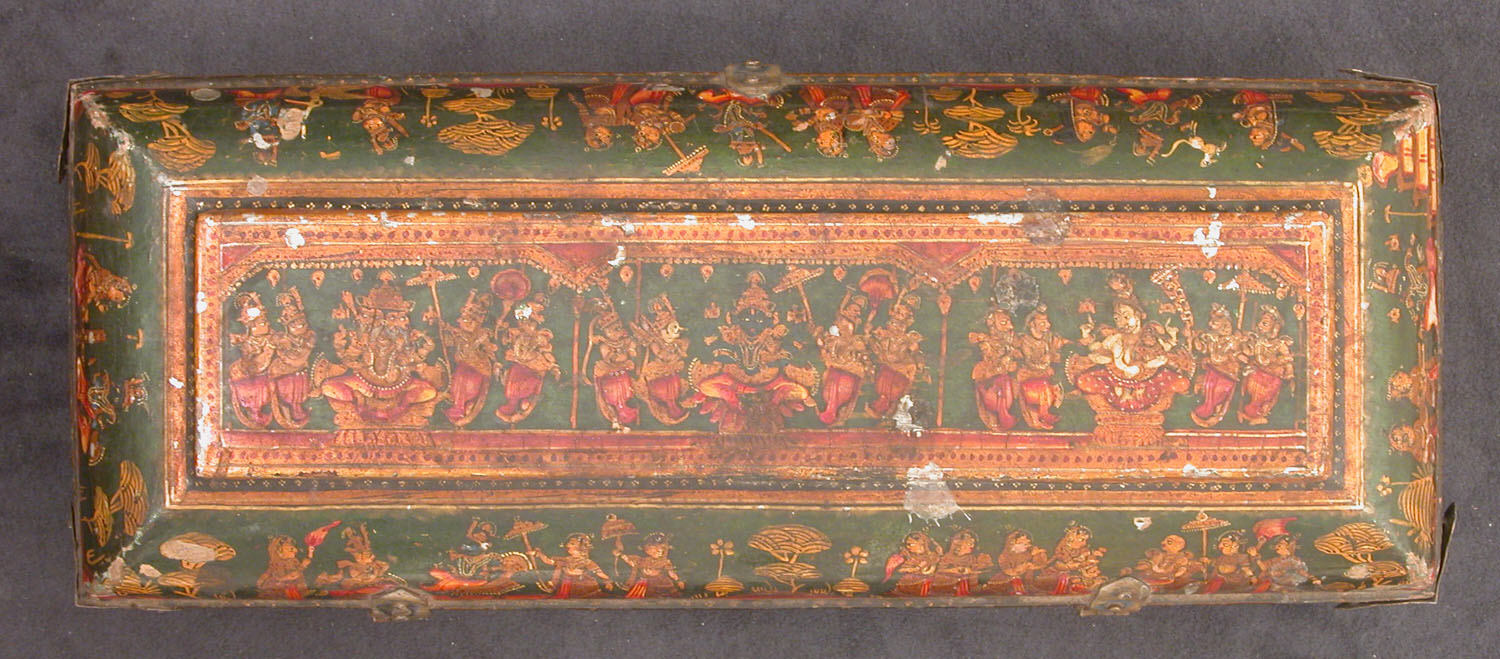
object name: box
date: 1701-1900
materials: lacquer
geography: india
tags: brahma,shiva,vishnu